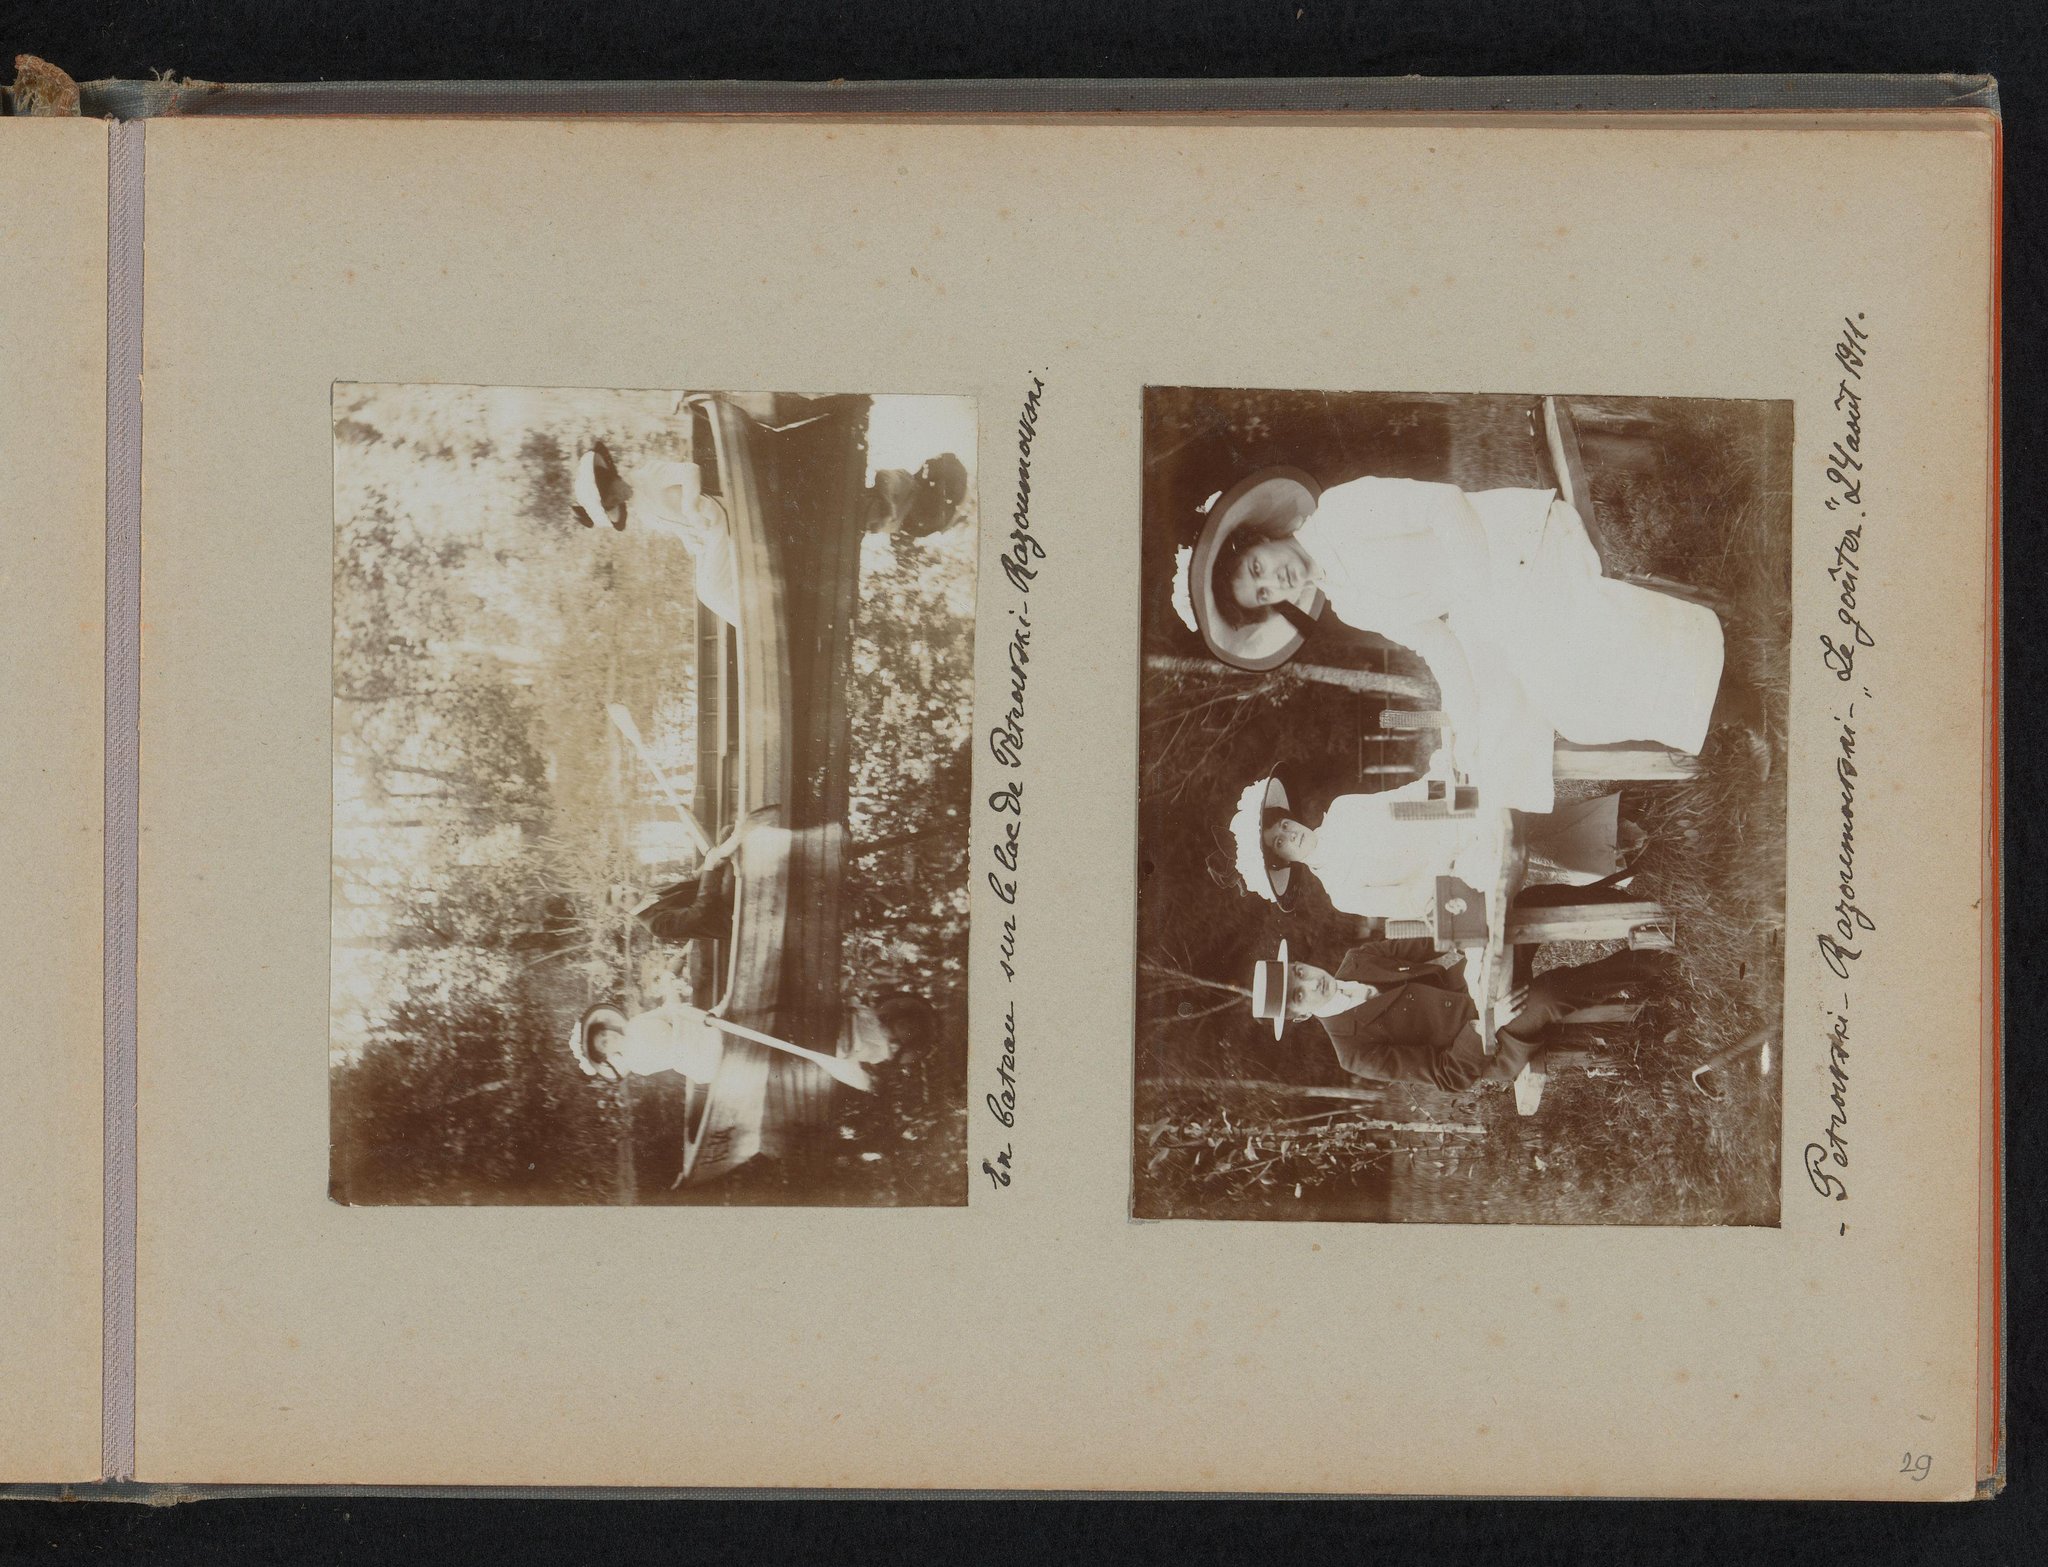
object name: album leaf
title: Twee vrouwen en een man in een roeiboot en aan een picknicktafel in het bos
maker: Anonymous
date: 1911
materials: paper, cardboard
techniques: collodion silver print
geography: russia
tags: historical persons, rowing-boat, canoe, etc., forest, wood, russia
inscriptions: inscription: ‘En bateau sur le lace de Petrovski-Razoemovski’, inscription: ‘- Petrovski-Razoemovski - "Le goûter". 24 août. 1911.’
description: Deze foto's maken deel uit van een album.